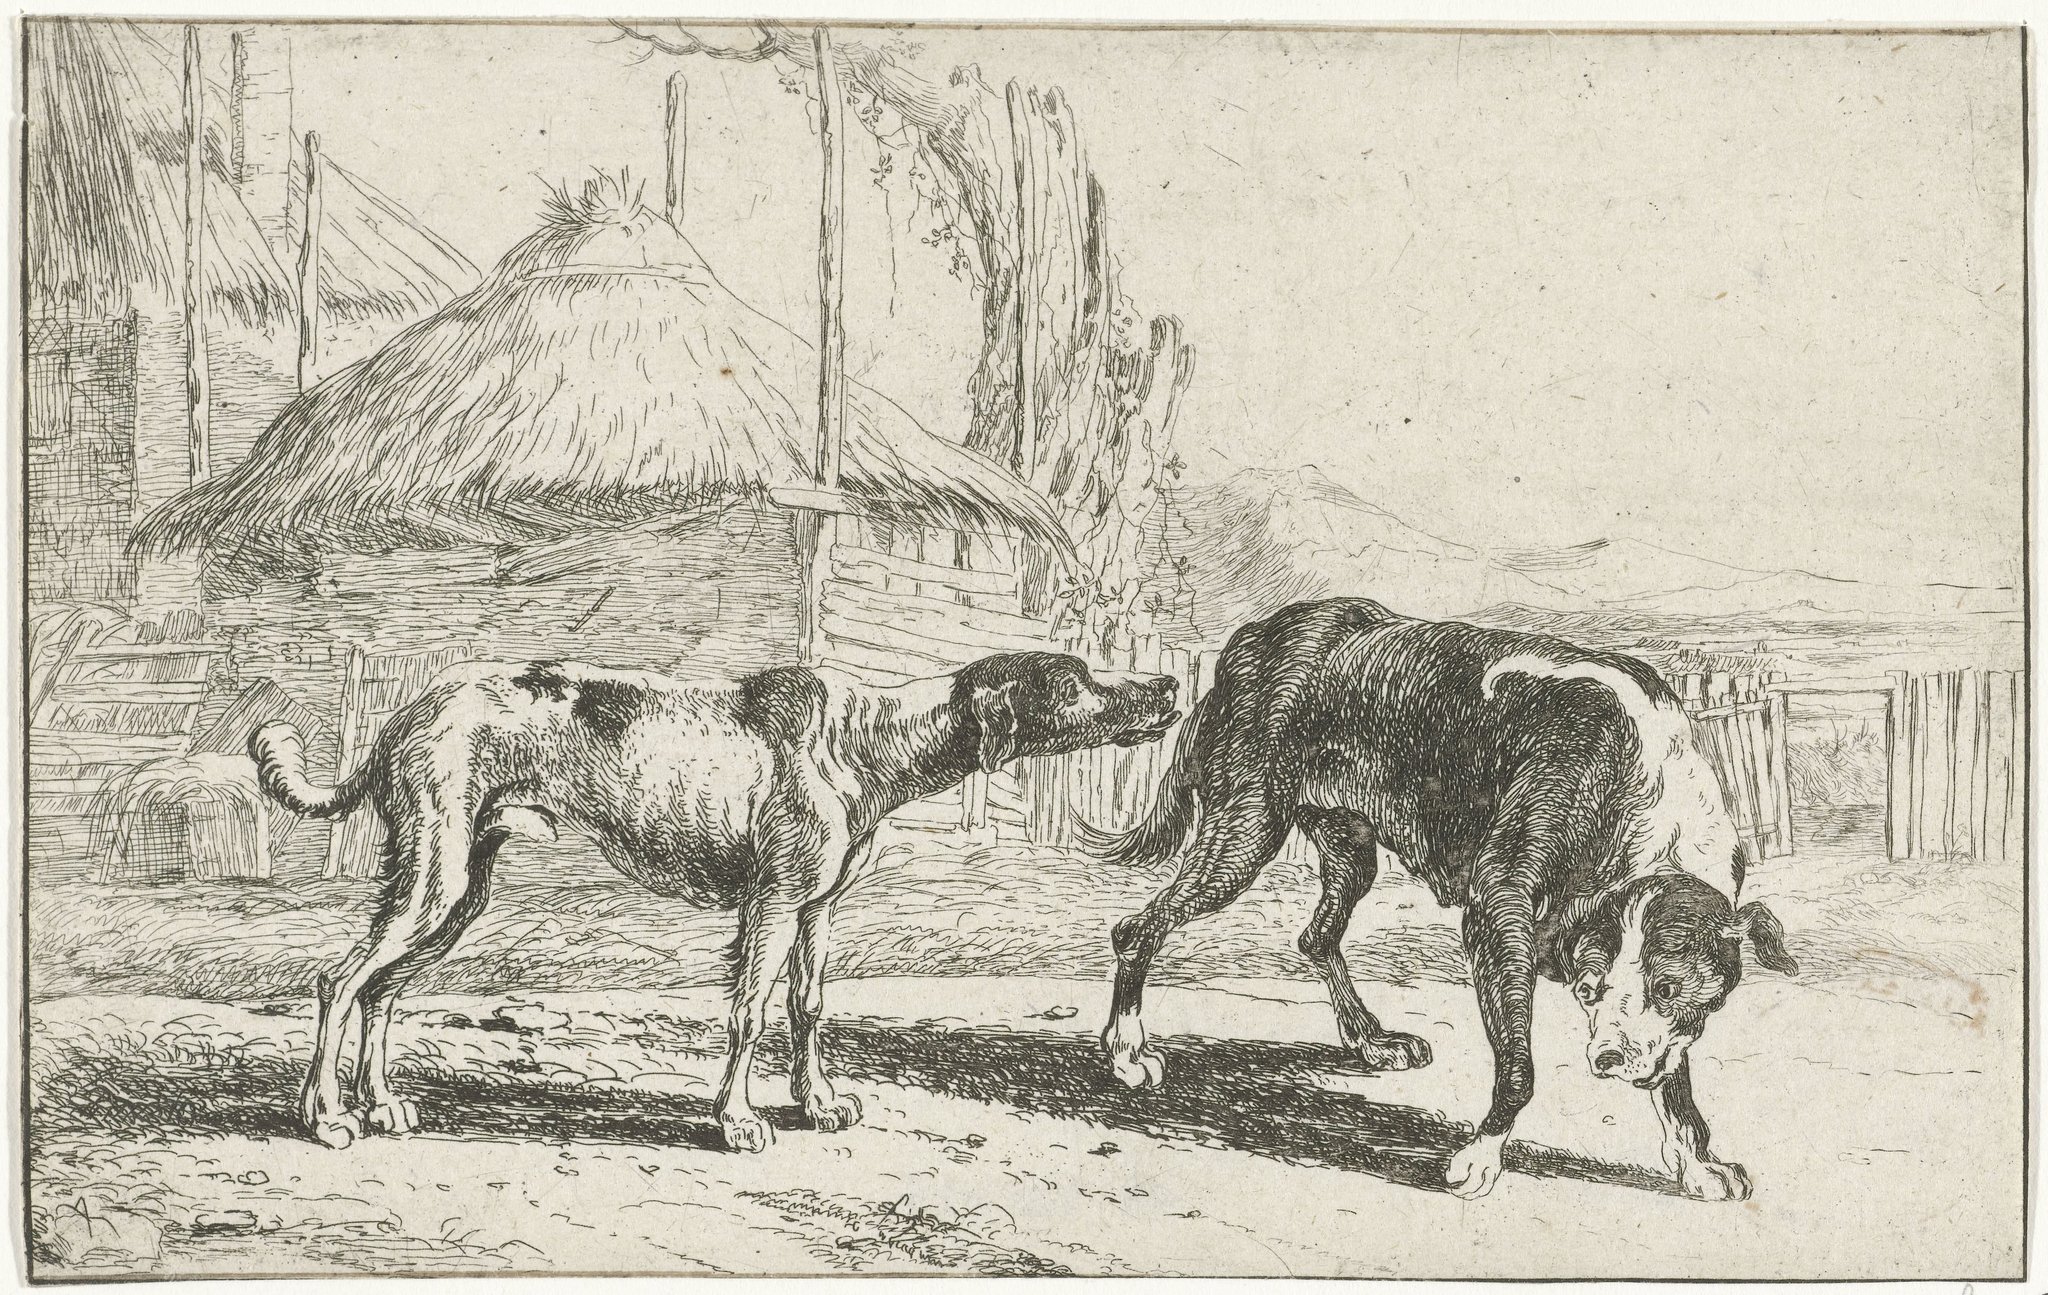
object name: print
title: Dieren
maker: jan van den hecke (i)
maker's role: print maker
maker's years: 1619-1684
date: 1656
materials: paper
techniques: etching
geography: brussels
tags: hay-stack, dog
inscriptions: collector's mark: Lugt 240